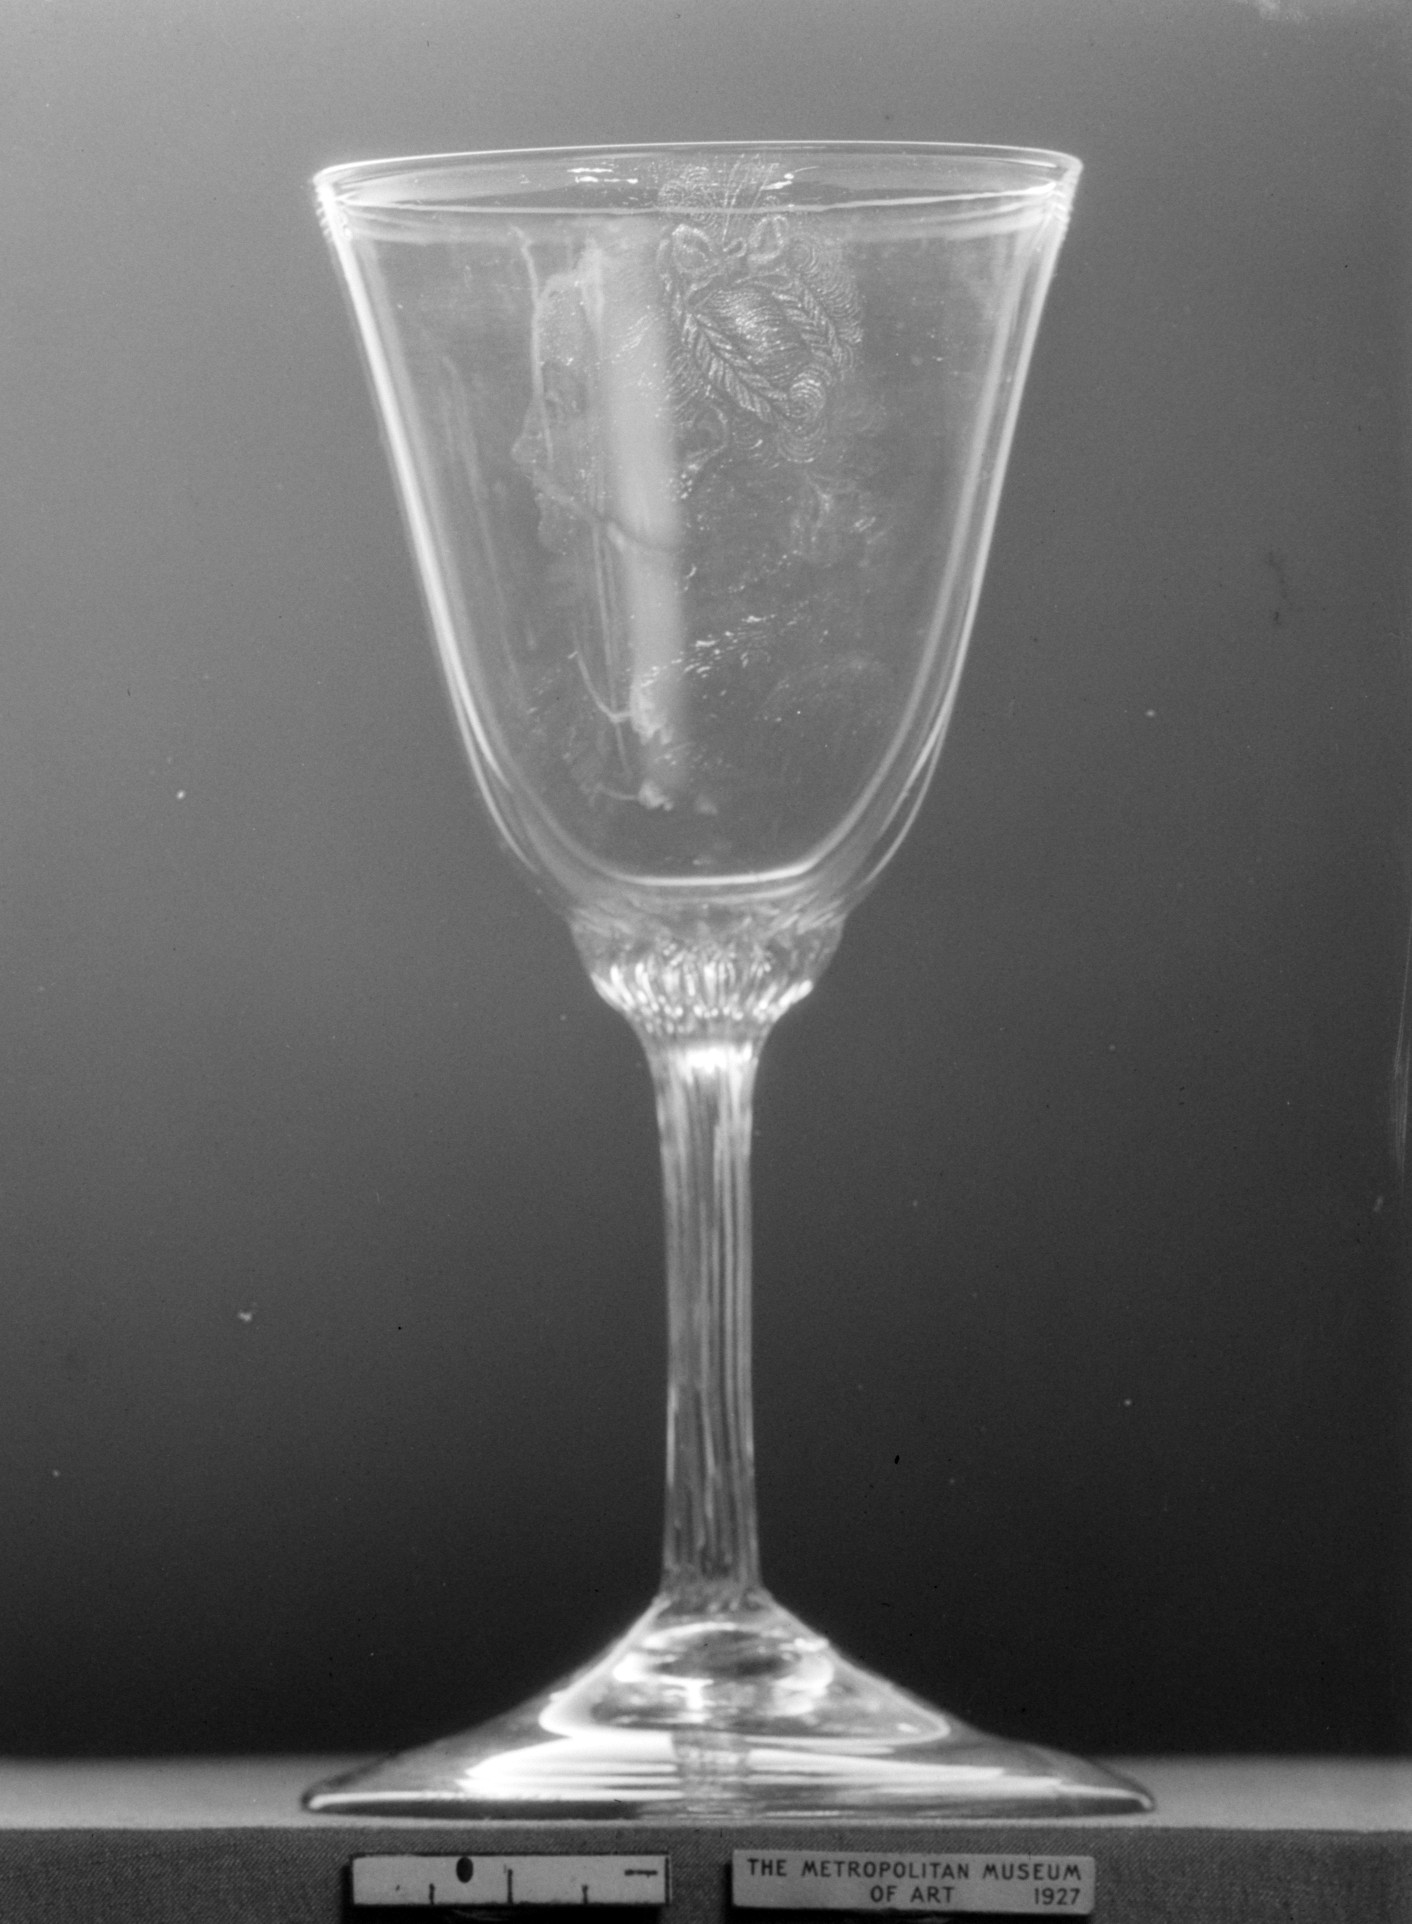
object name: wineglass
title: Wineglass with Catherine II of Russia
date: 1790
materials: glass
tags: profiles,women